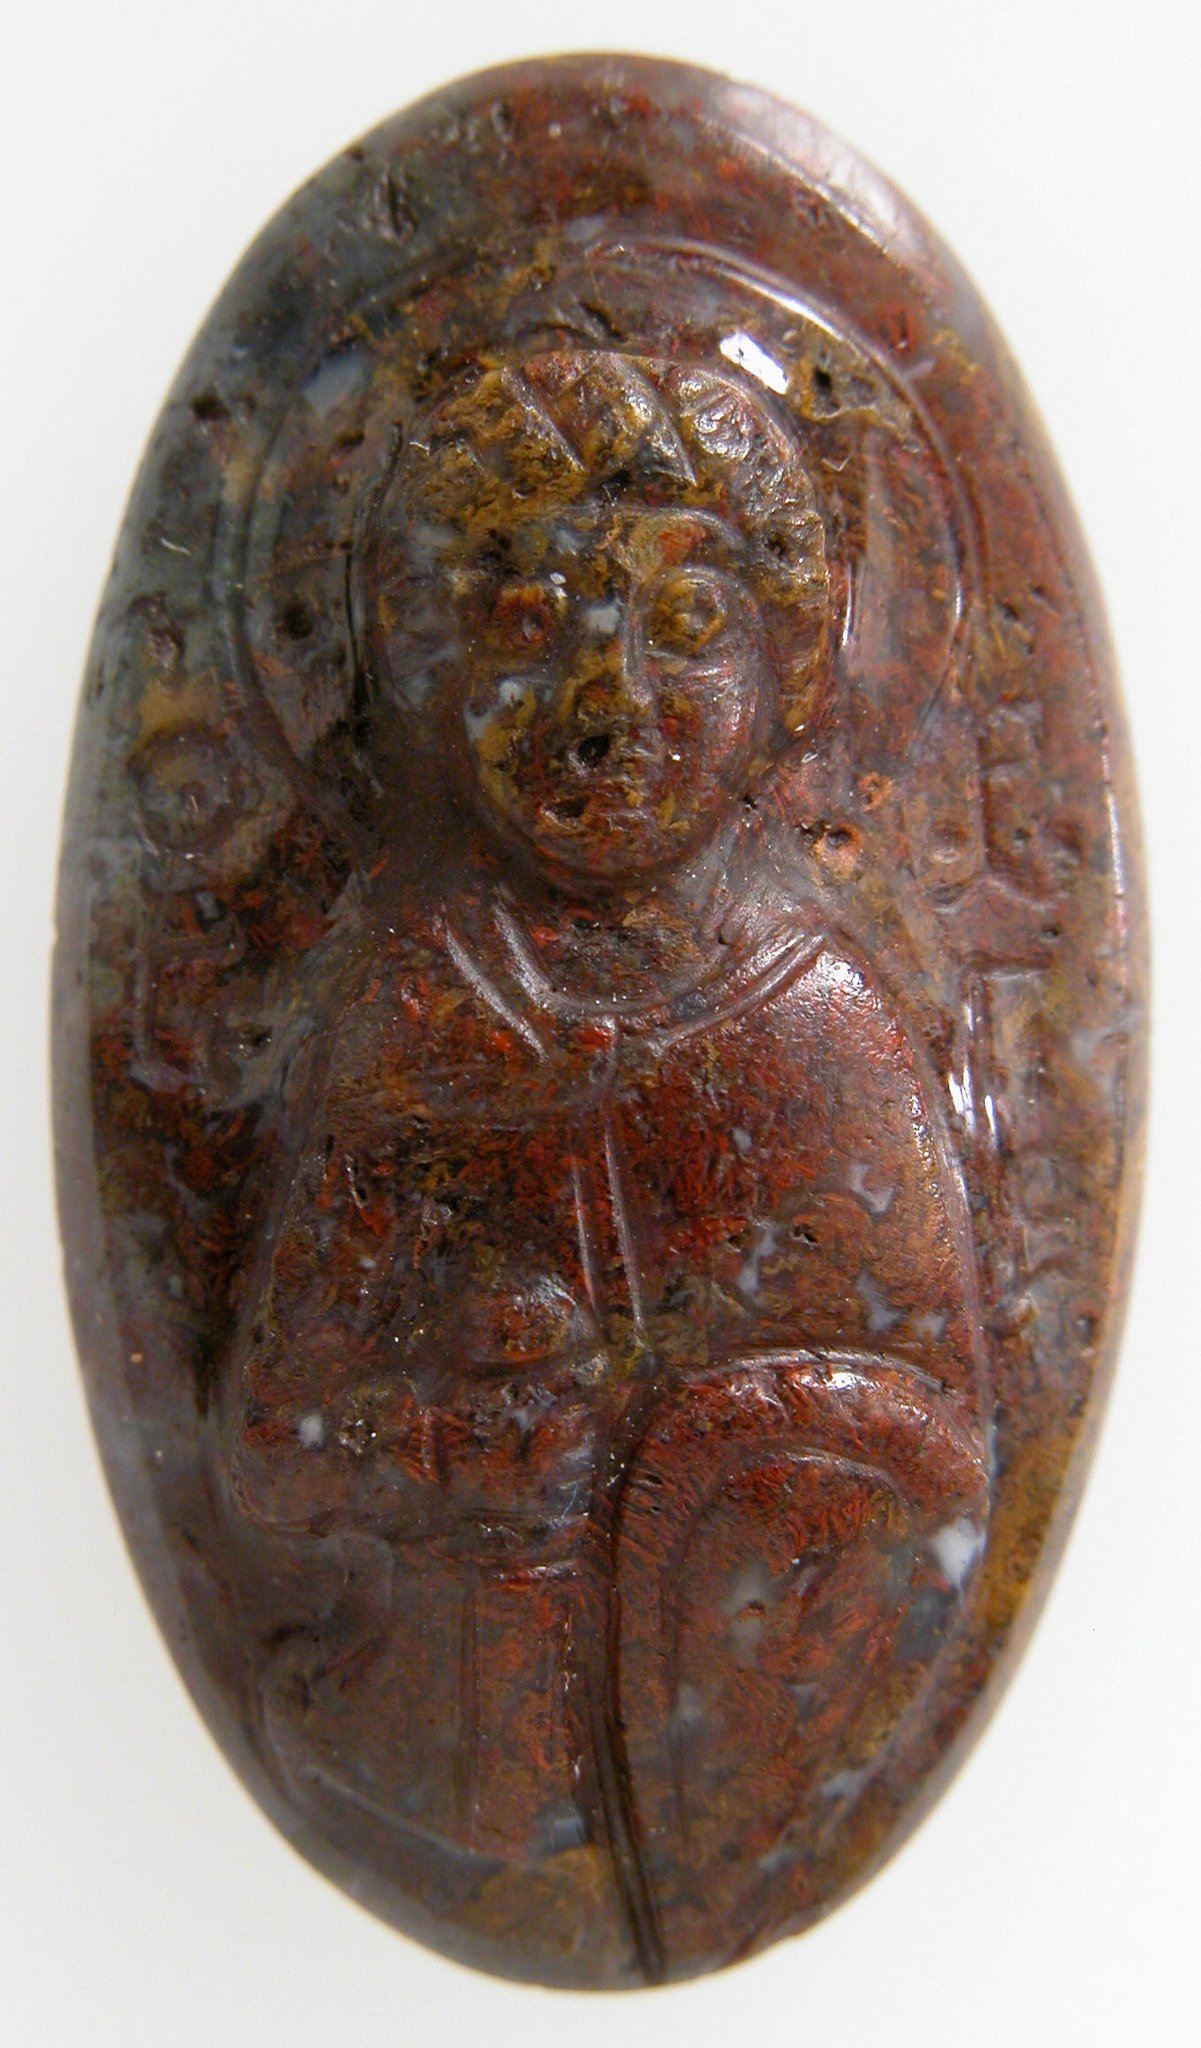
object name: cameo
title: Cameo with Saint George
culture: byzantine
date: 1100-1300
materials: jasper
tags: saint george